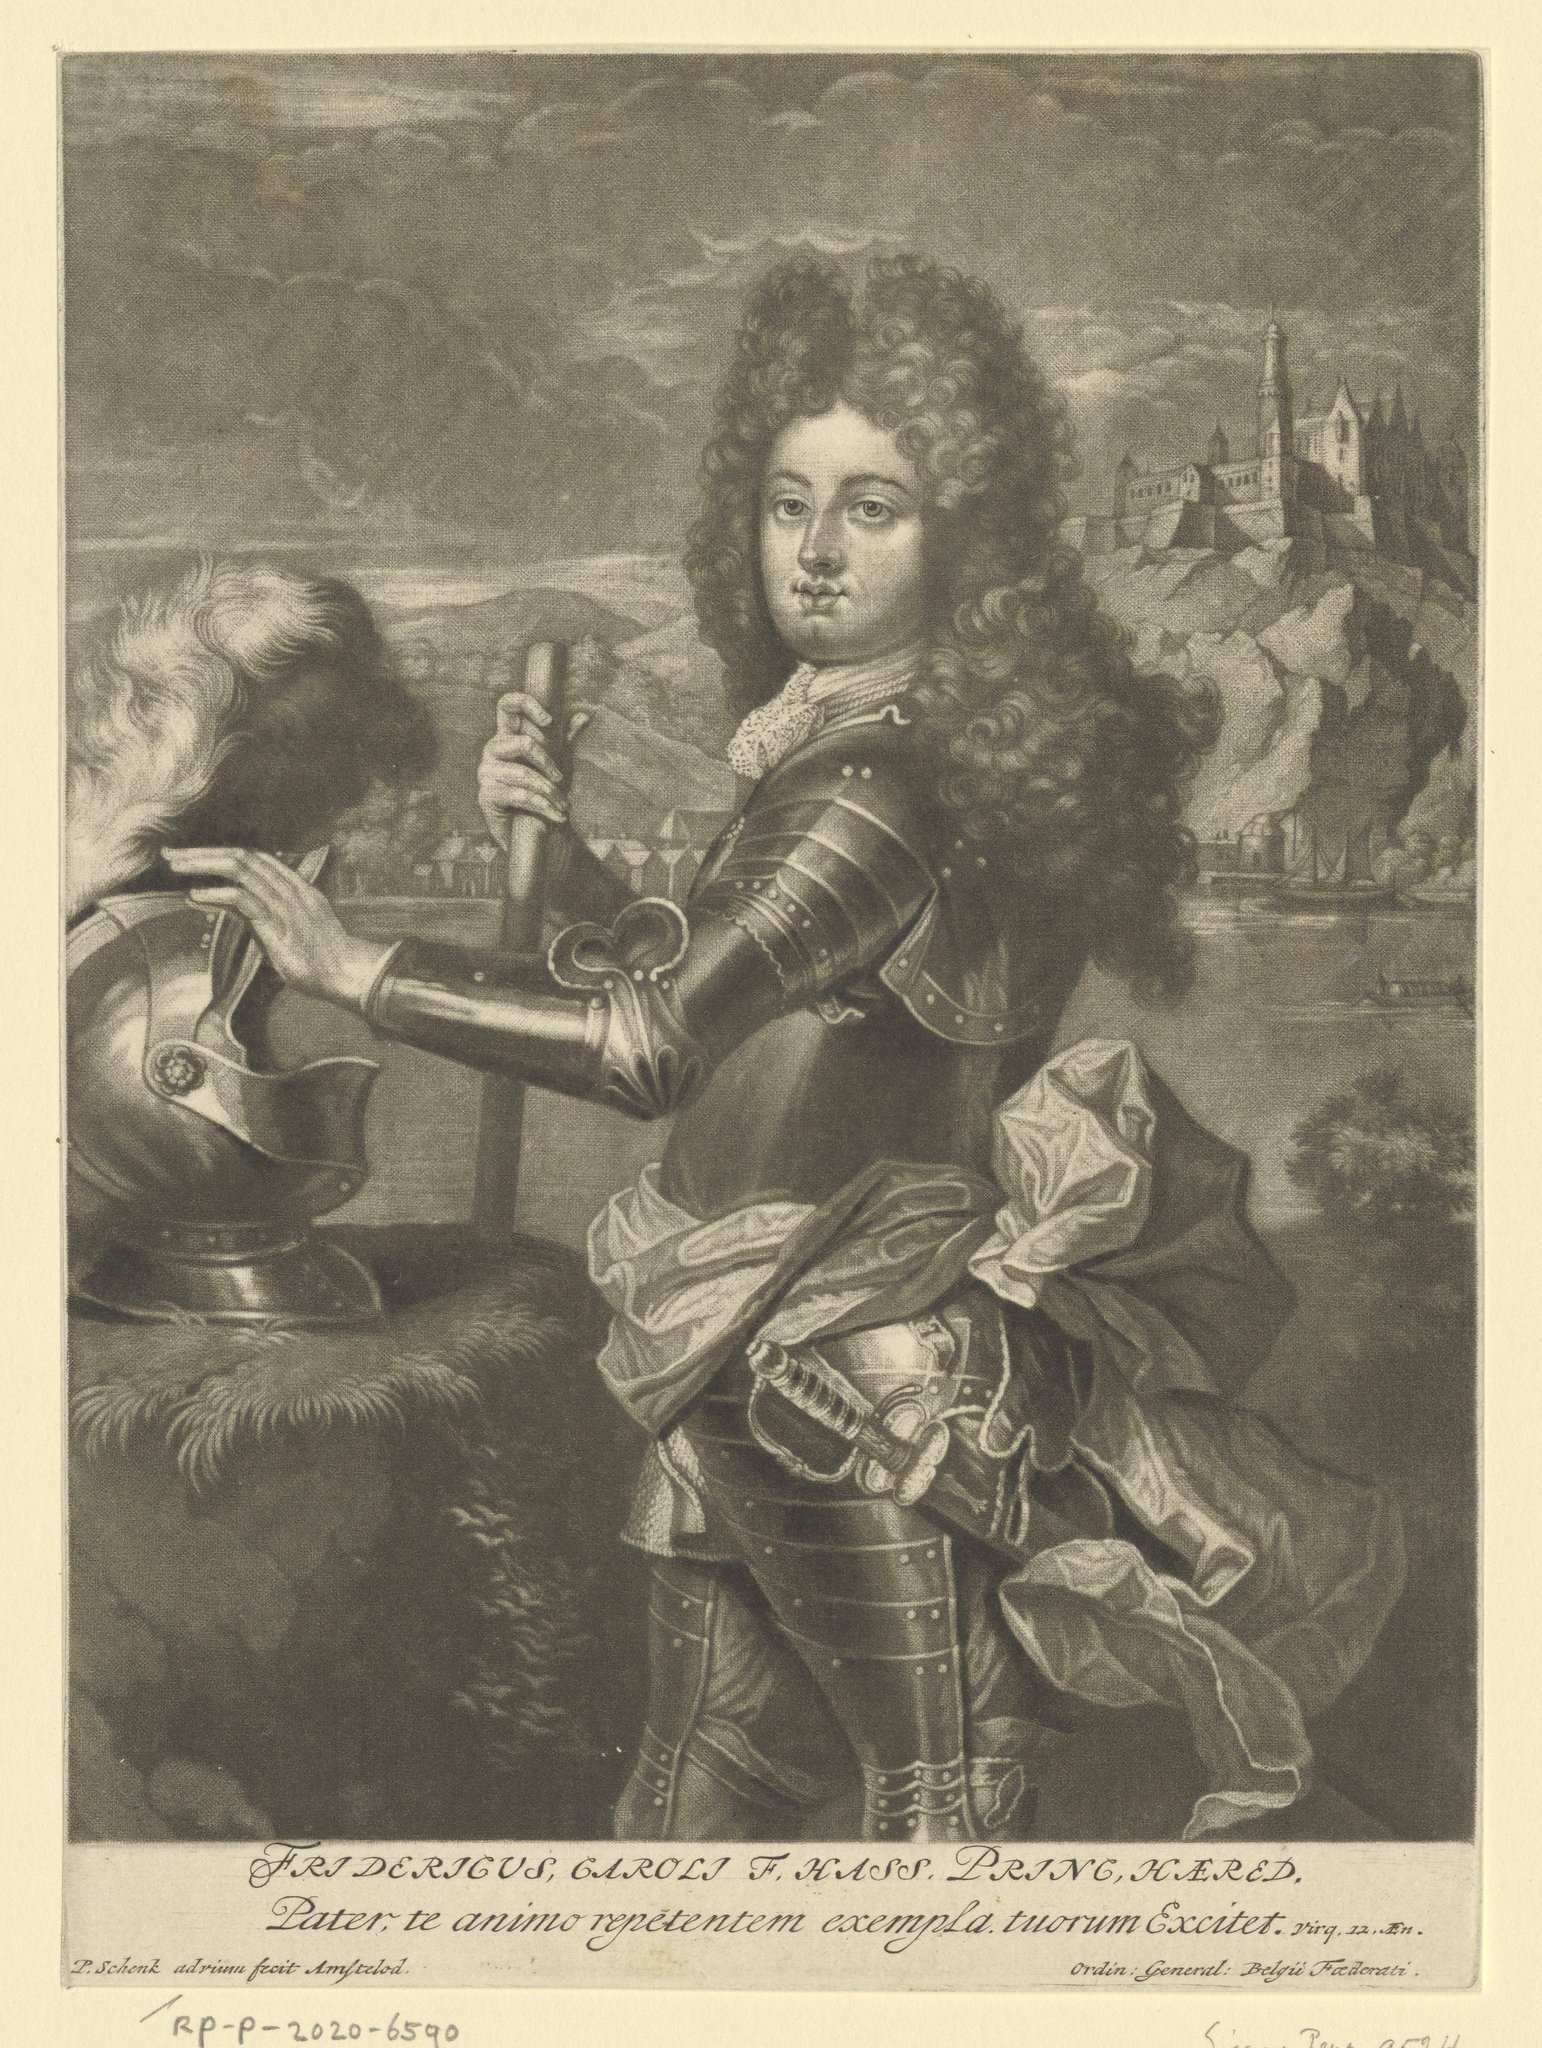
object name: print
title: Portret van Frederik I van Zweden als prins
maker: pieter schenk (i)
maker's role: print maker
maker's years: 1660-1711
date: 1695-1713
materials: paper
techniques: engraving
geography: amsterdam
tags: frederik i (koning van zweden), river, armour, historical persons, landscape with tower or castle